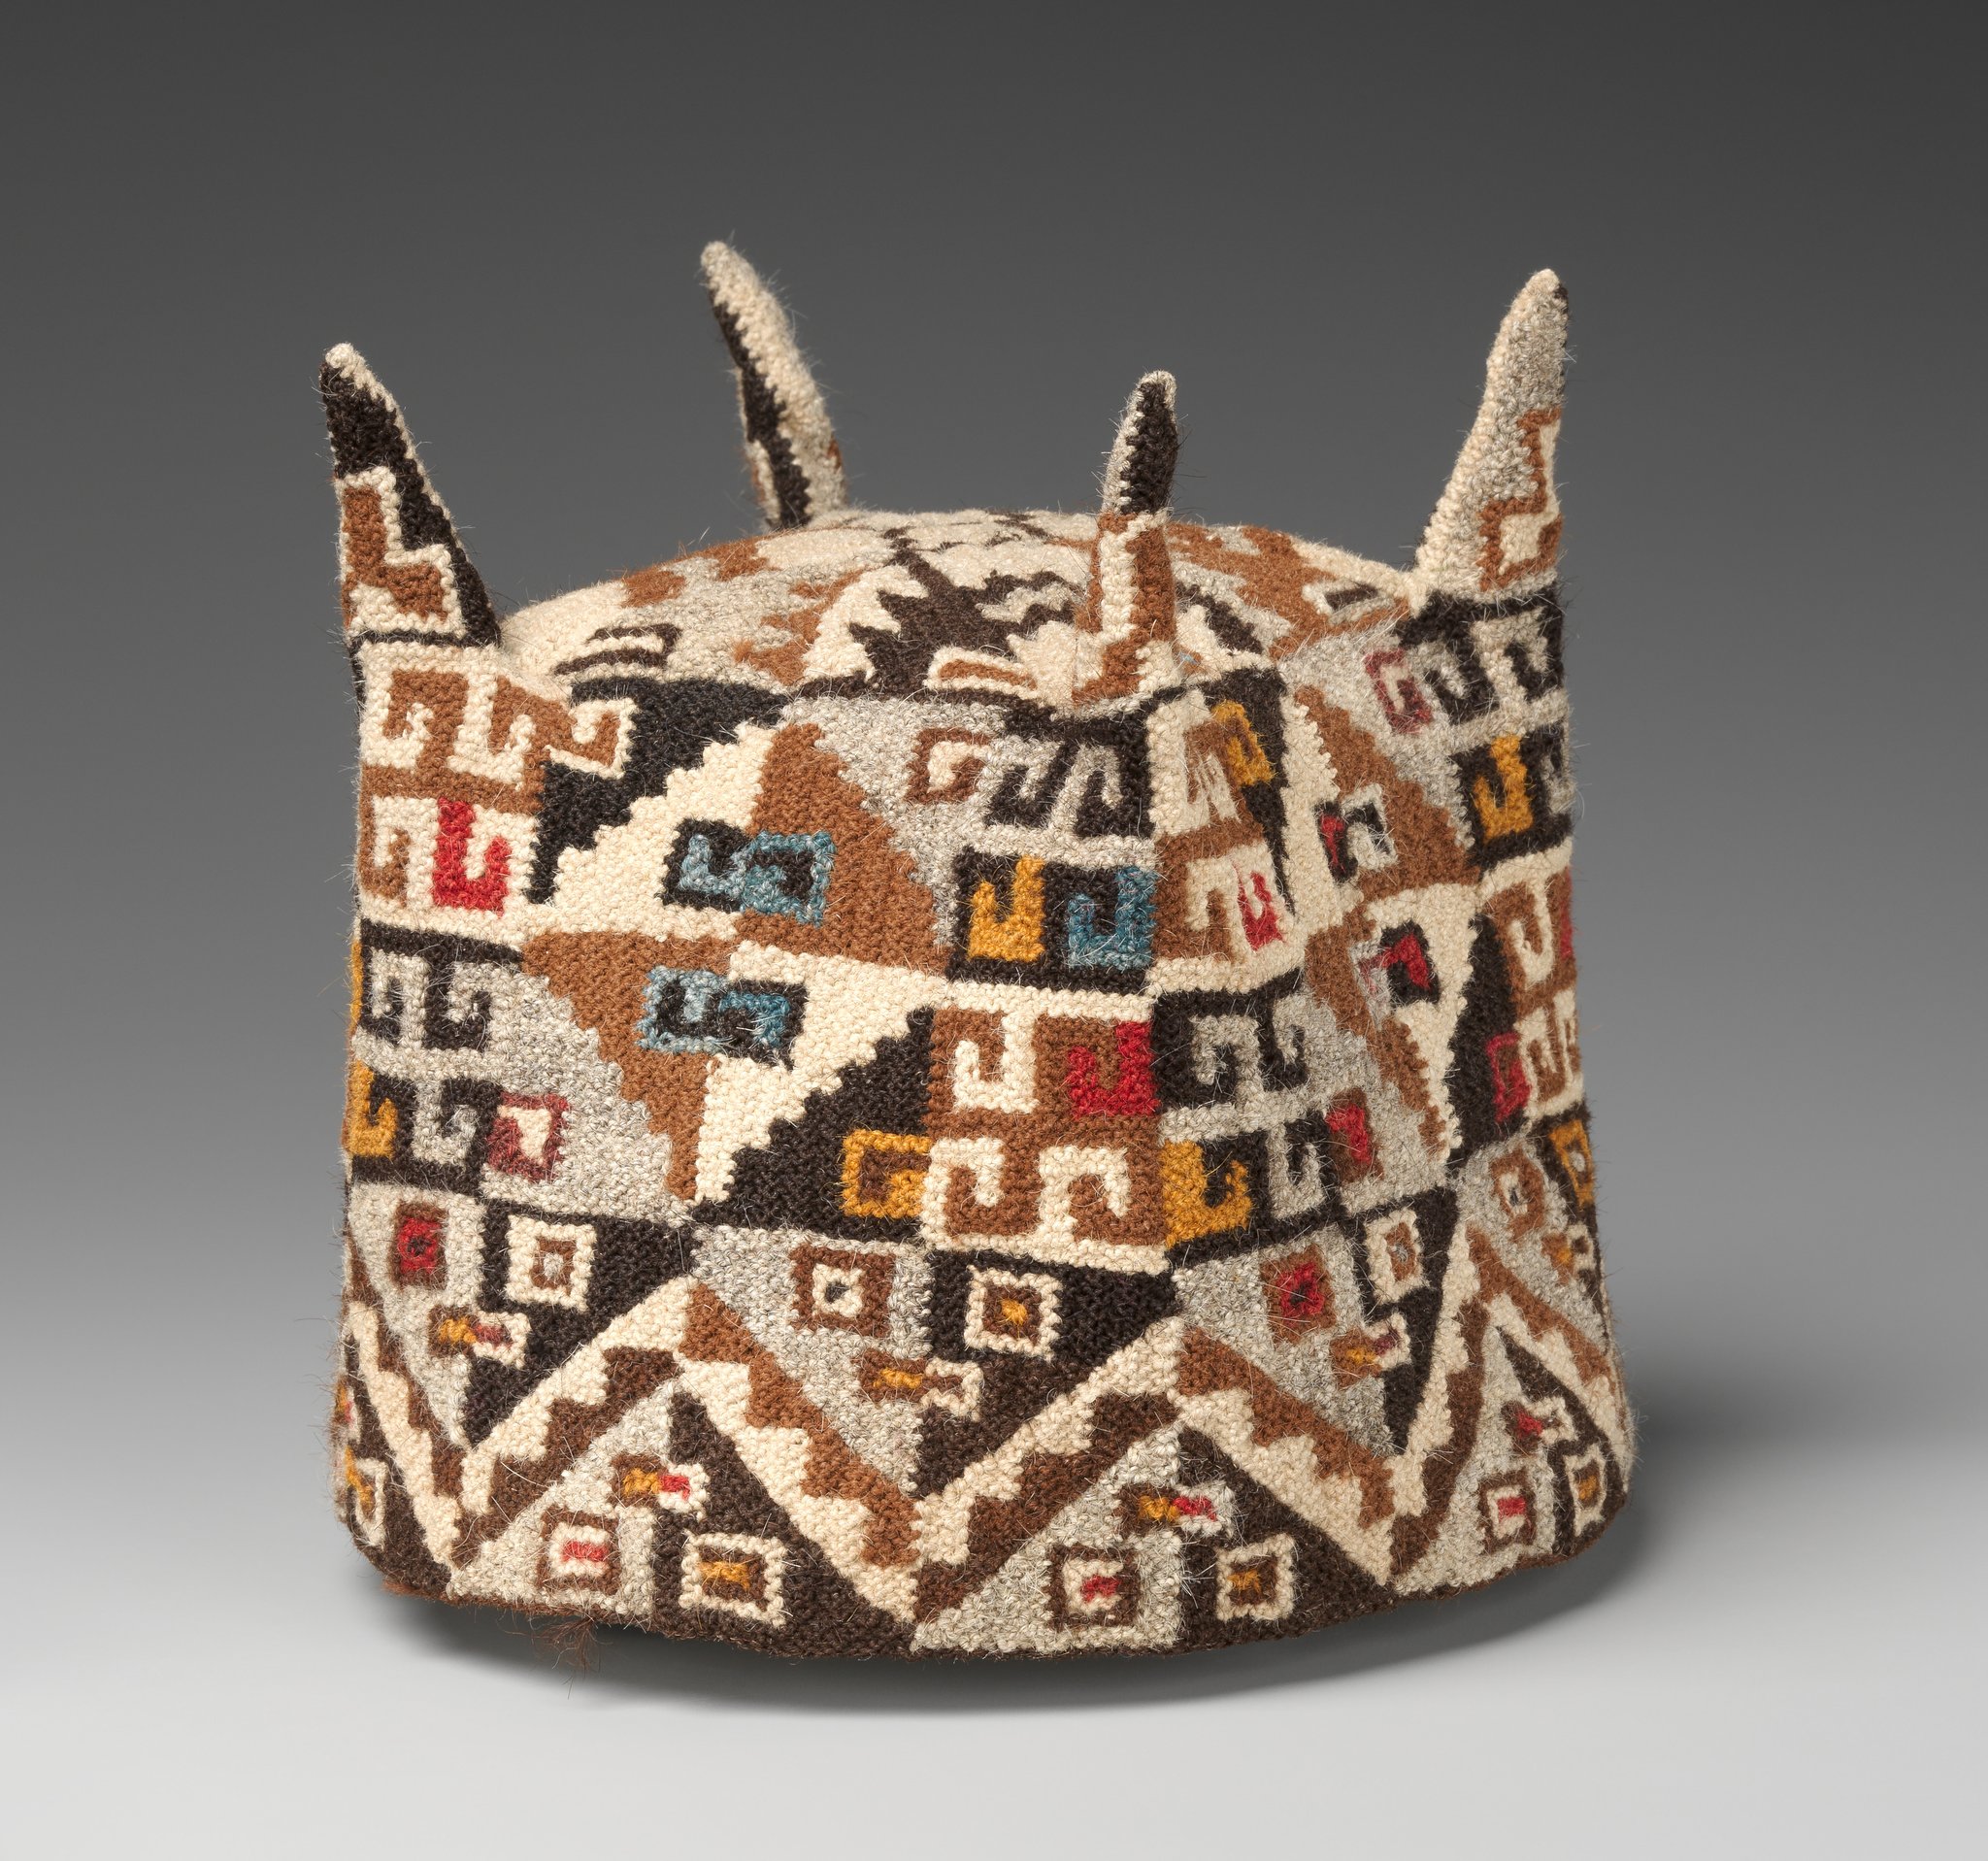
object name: hat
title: Four-Cornered Hat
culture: tiwanaku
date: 601-900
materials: animal fiber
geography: bolivia